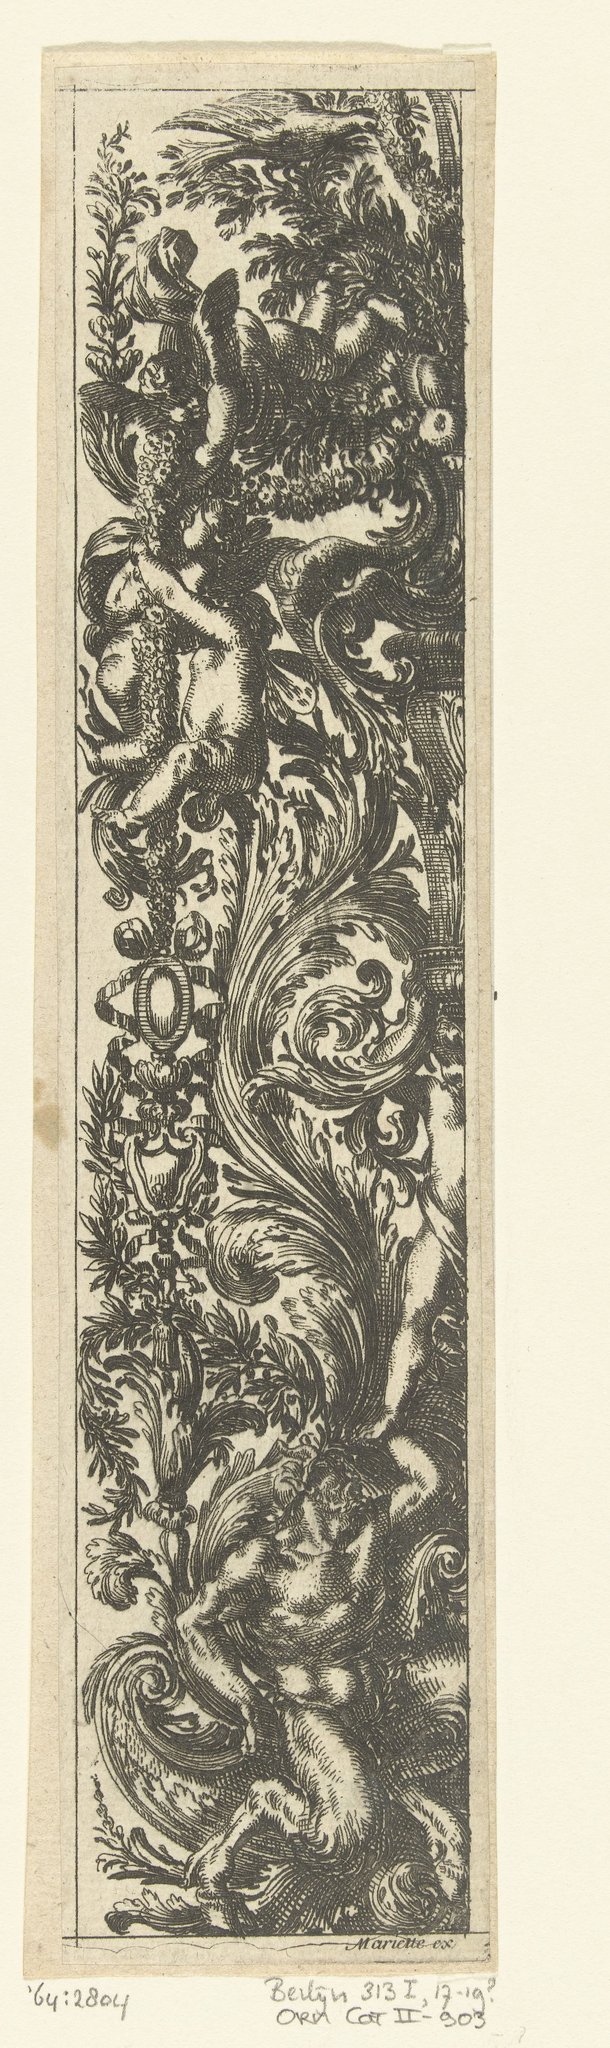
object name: ornament print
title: Paneel met sater en putti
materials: paper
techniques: etching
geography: france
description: Putti spelend met een guirlande van bloemen.